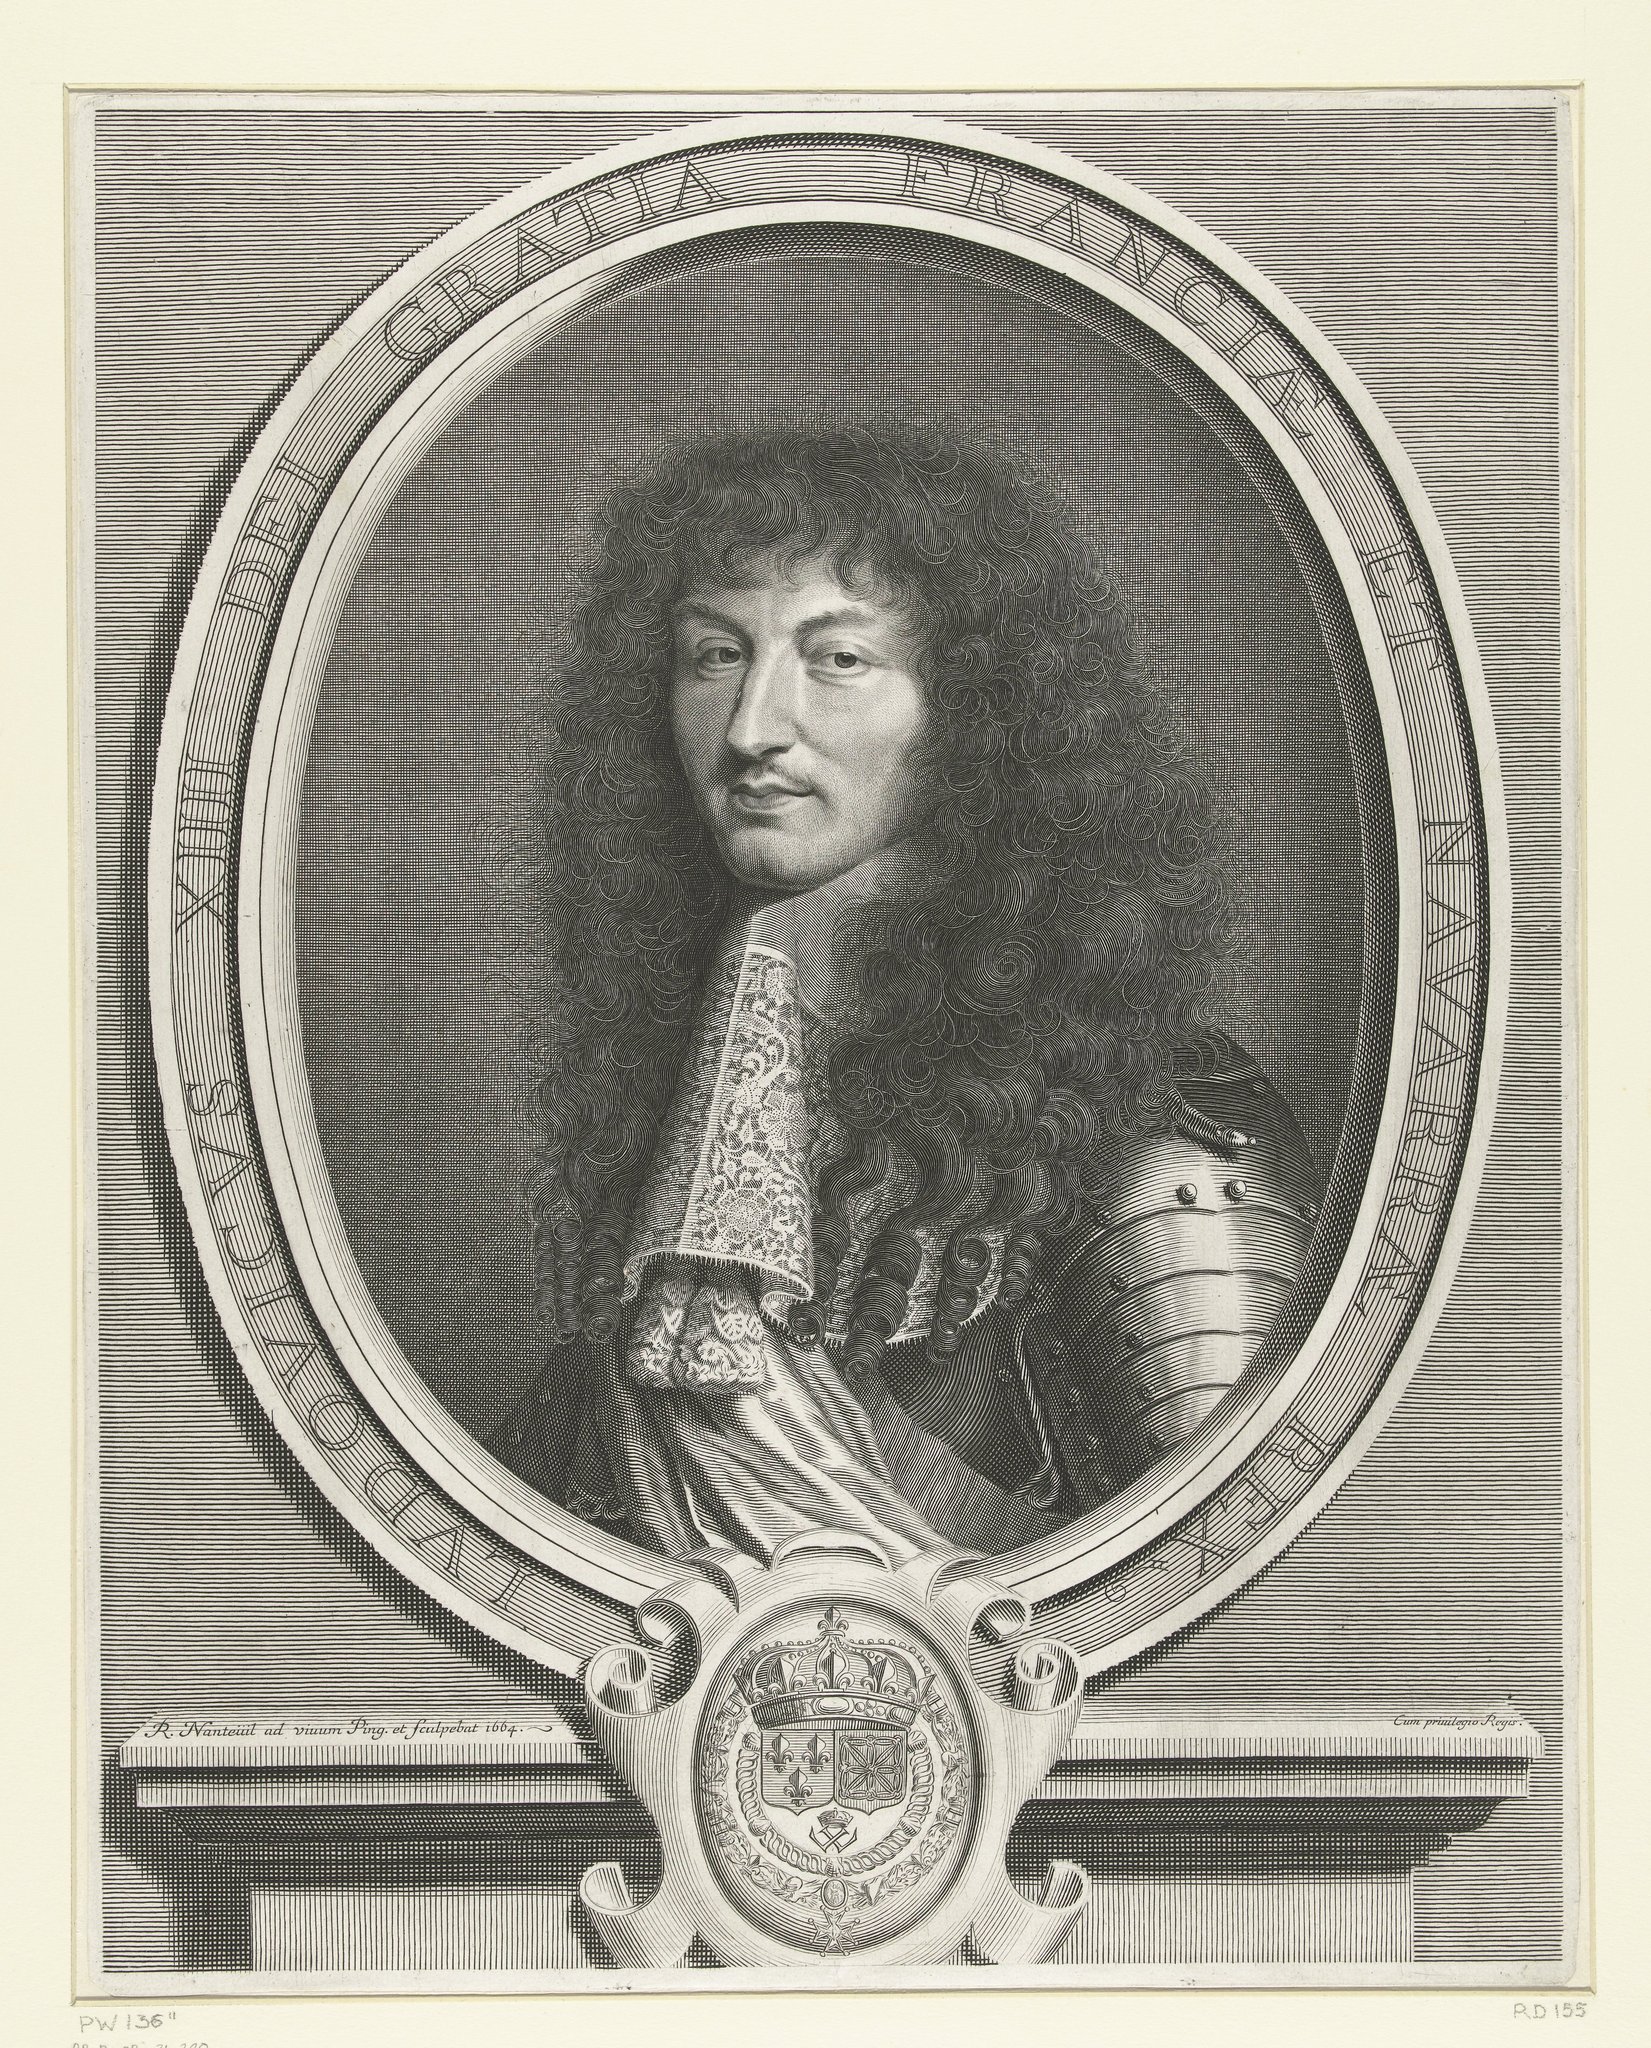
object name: print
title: Portret van Lodewijk XIV, koning van Frankrijk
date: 1664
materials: paper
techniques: engraving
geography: france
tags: lodewijk xiv (koning van frankrijk)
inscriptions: collector's mark: Lugt 240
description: Portret van Lodewijk XIV, koning van Frankrijk, in een harnas met kanten kraag en een lange krulpruik. Een ovale omlijsting met tekst, onderaan een cartouche met een wapenschild.